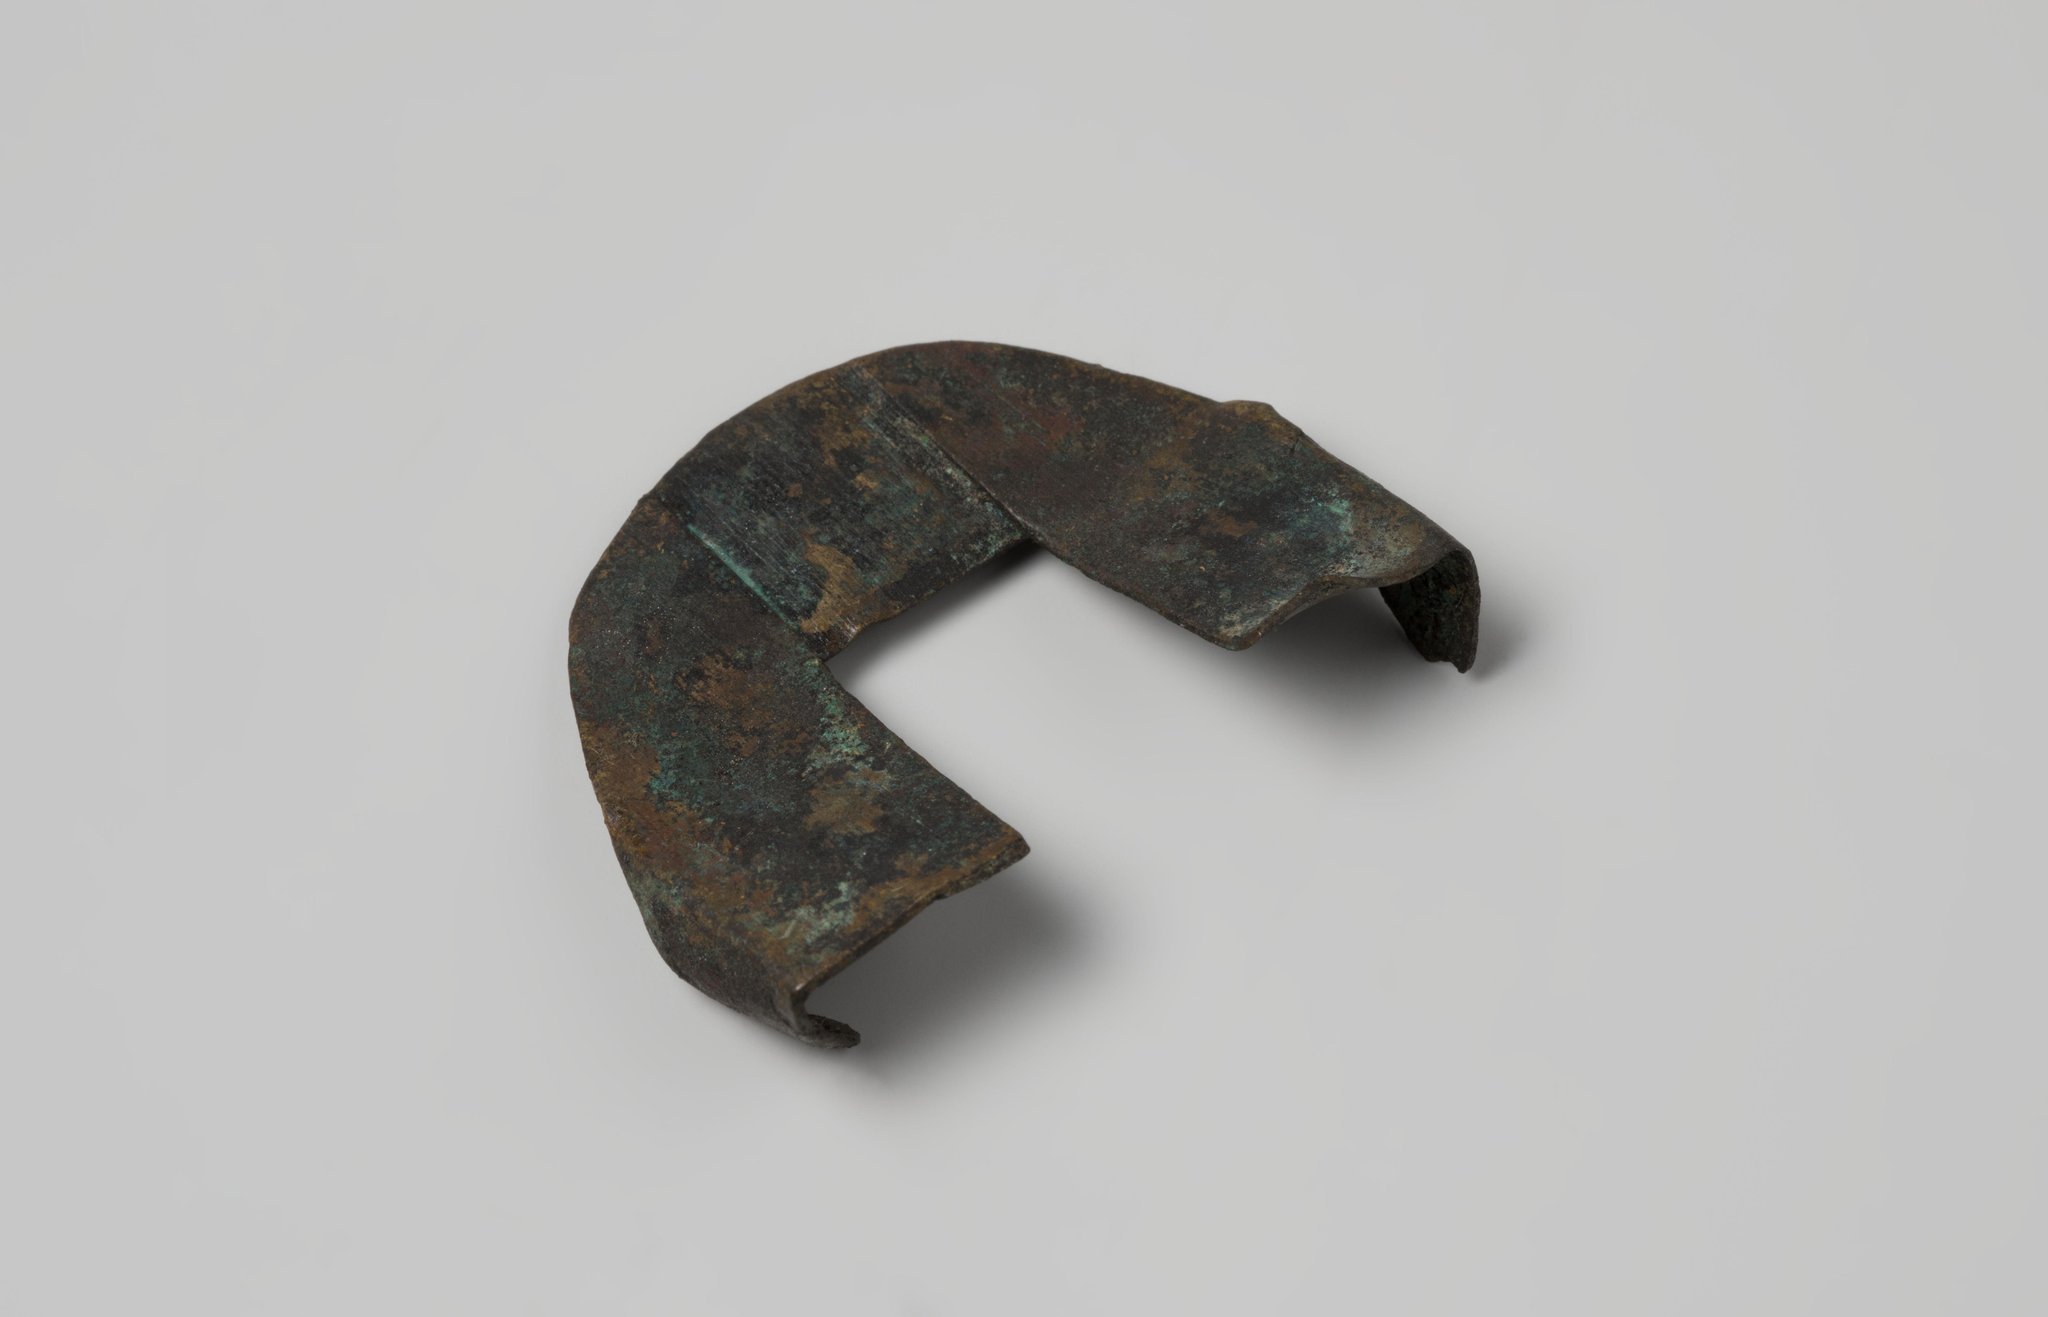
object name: graadstok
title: Vizier van de jacobsstaf uit het wrak van de Oost-Indiëvaarder Hollandia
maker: Anonymous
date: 1700-1743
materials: copper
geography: netherlands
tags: verenigde oostindische compagnie, hollandia (schip), annet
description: Navigation, cross staffs' vizor; consisting of 2 parallel strips, flat, straight, with one curved end, joined by a semicircular strip with straight bevelled rim, rectangular opening between strips, outer rims of both strips right-angled in the shape of triangular pointed lugs.